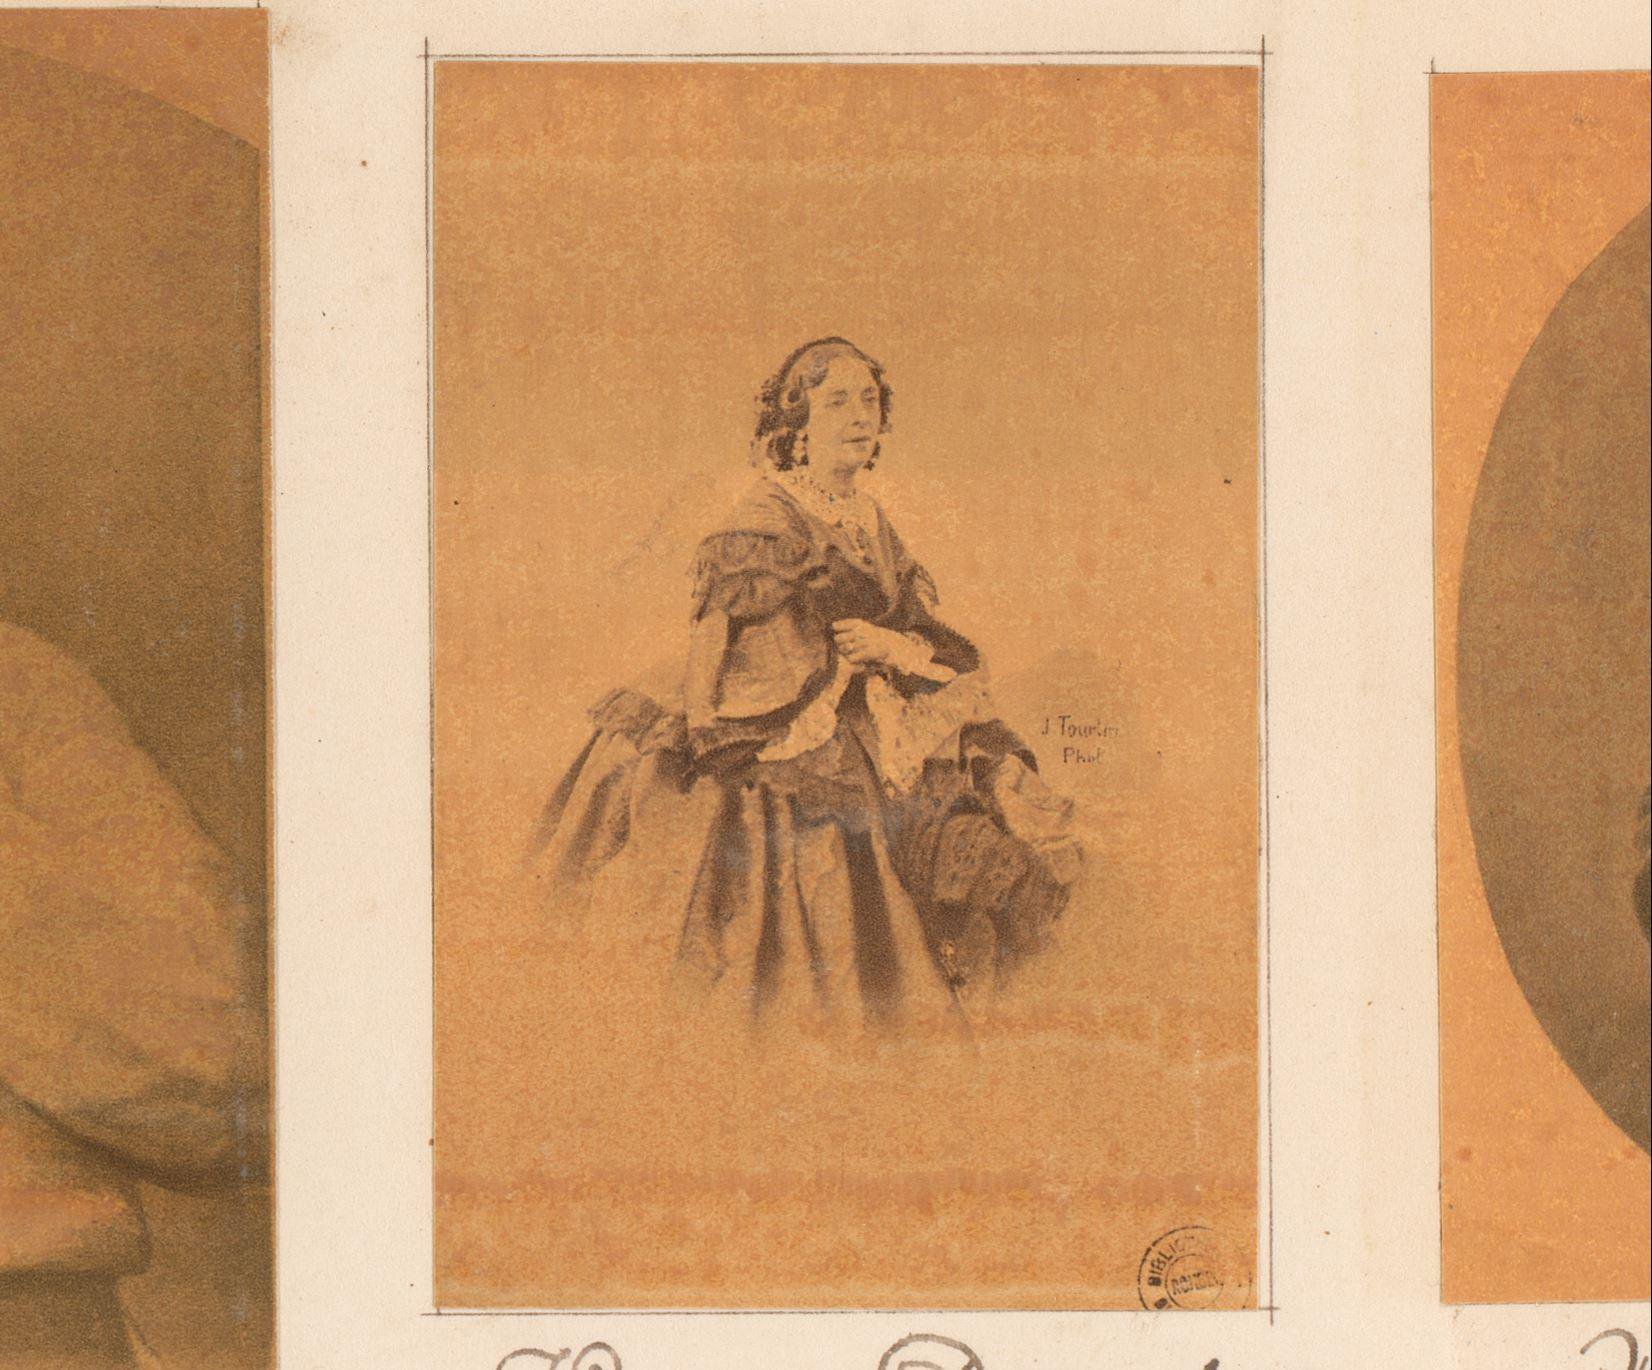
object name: album leaf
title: Virginie Déjazet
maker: Anonymous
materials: paper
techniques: rotogravure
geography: france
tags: portrait of actor, actress, france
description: Deze prent maakt deel uit van een album.